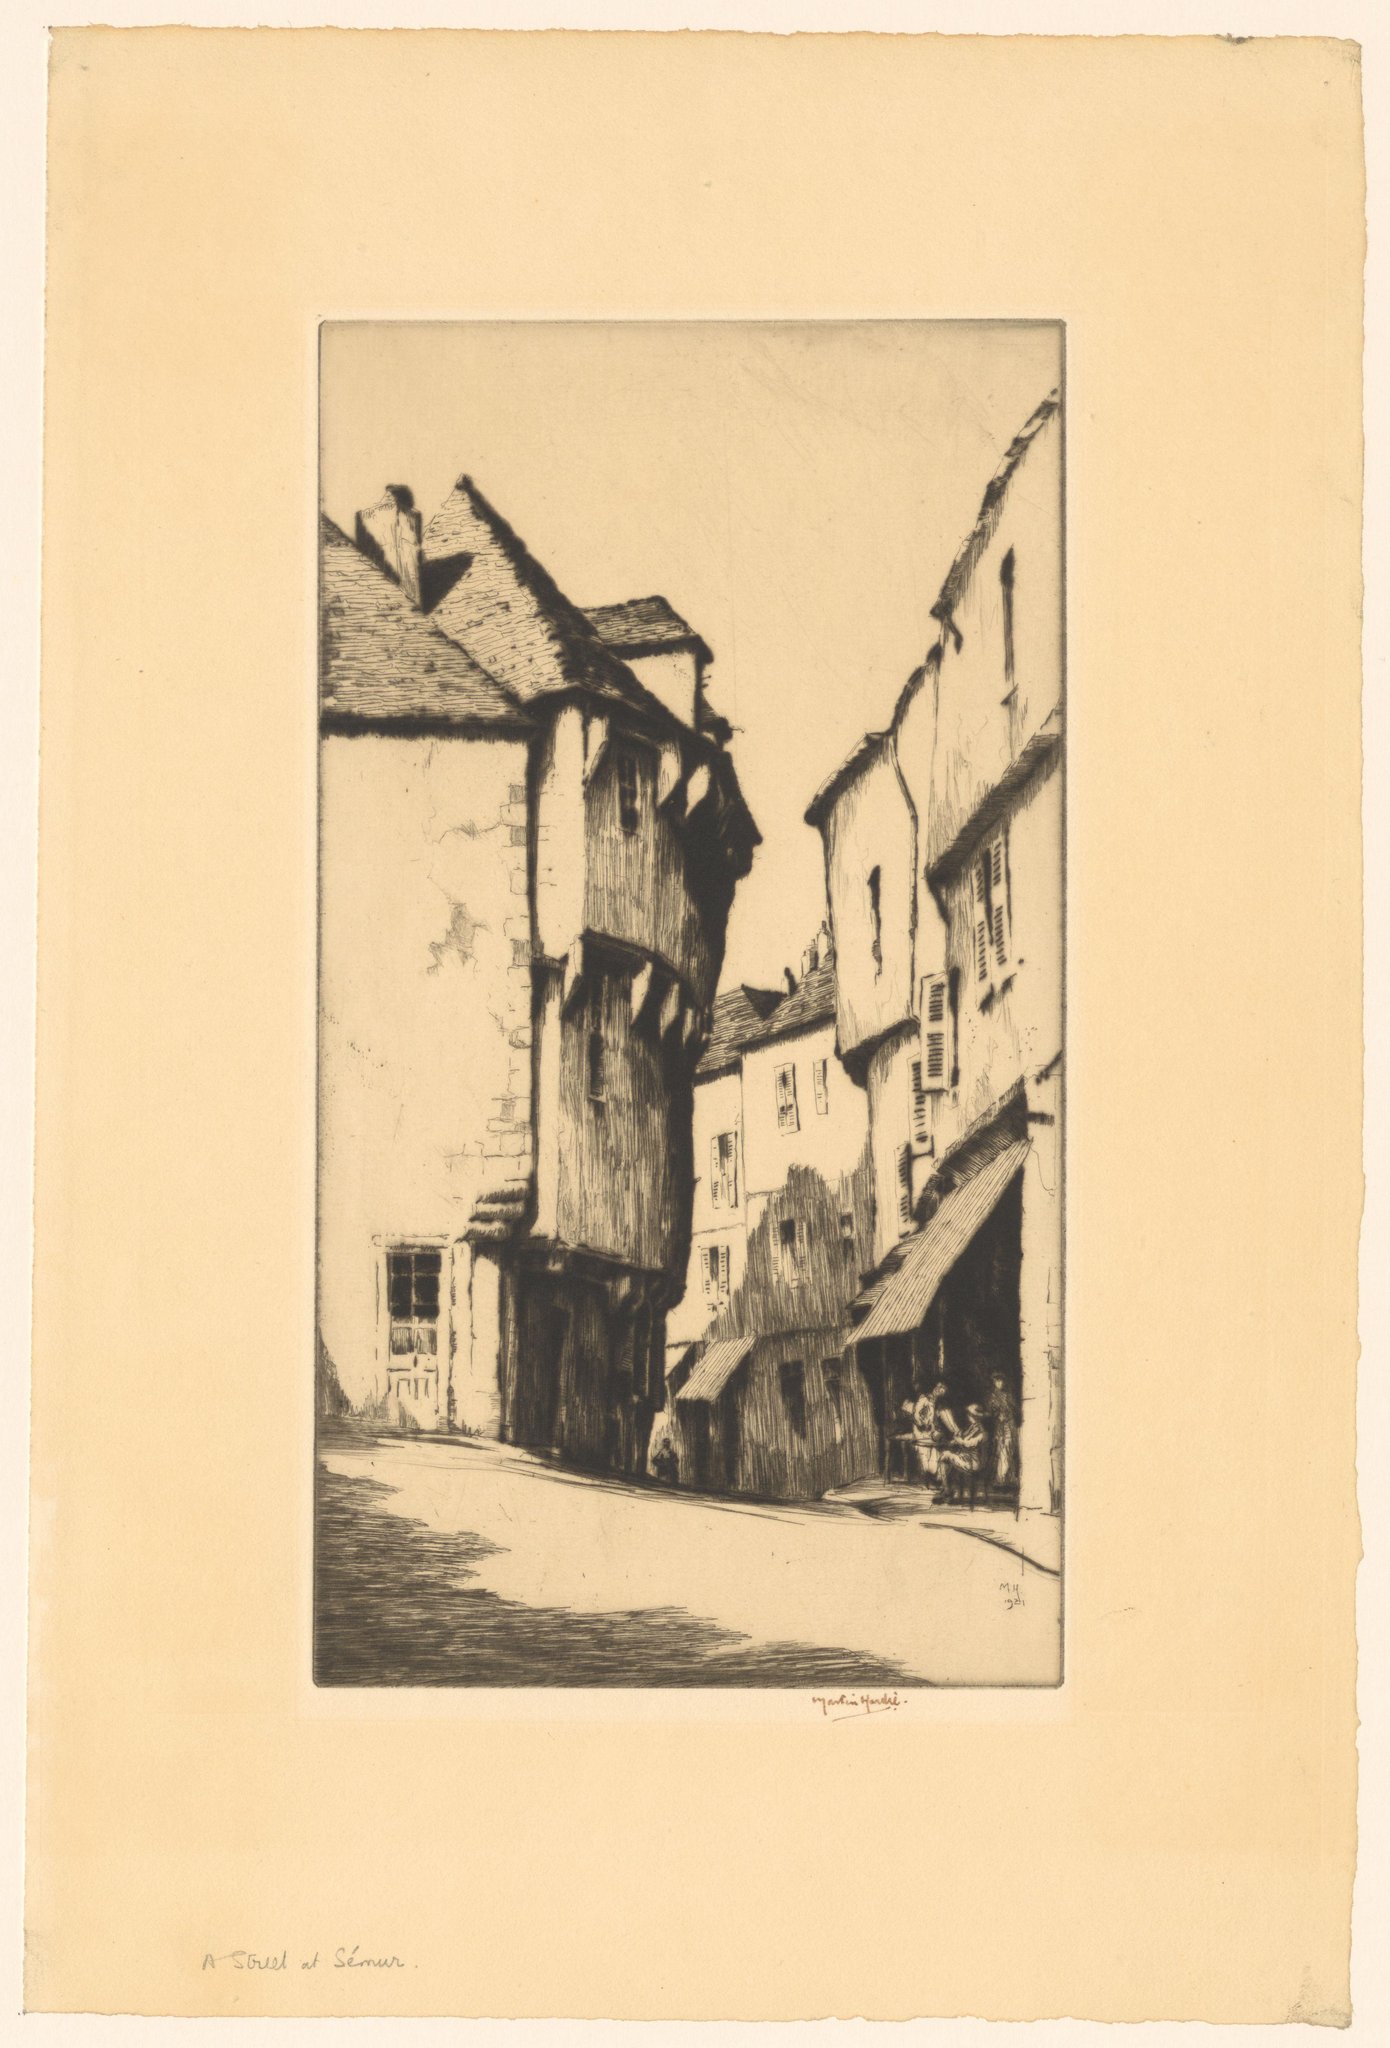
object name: print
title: Straat in Semur-en-Auxois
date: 1921-1926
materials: paper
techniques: drypoint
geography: semur-en-auxois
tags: city-view in general; 'veduta', sloping street; street with steps or stairs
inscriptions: collector's mark: Lugt 2228, annotation: ‘Martin Hardie’